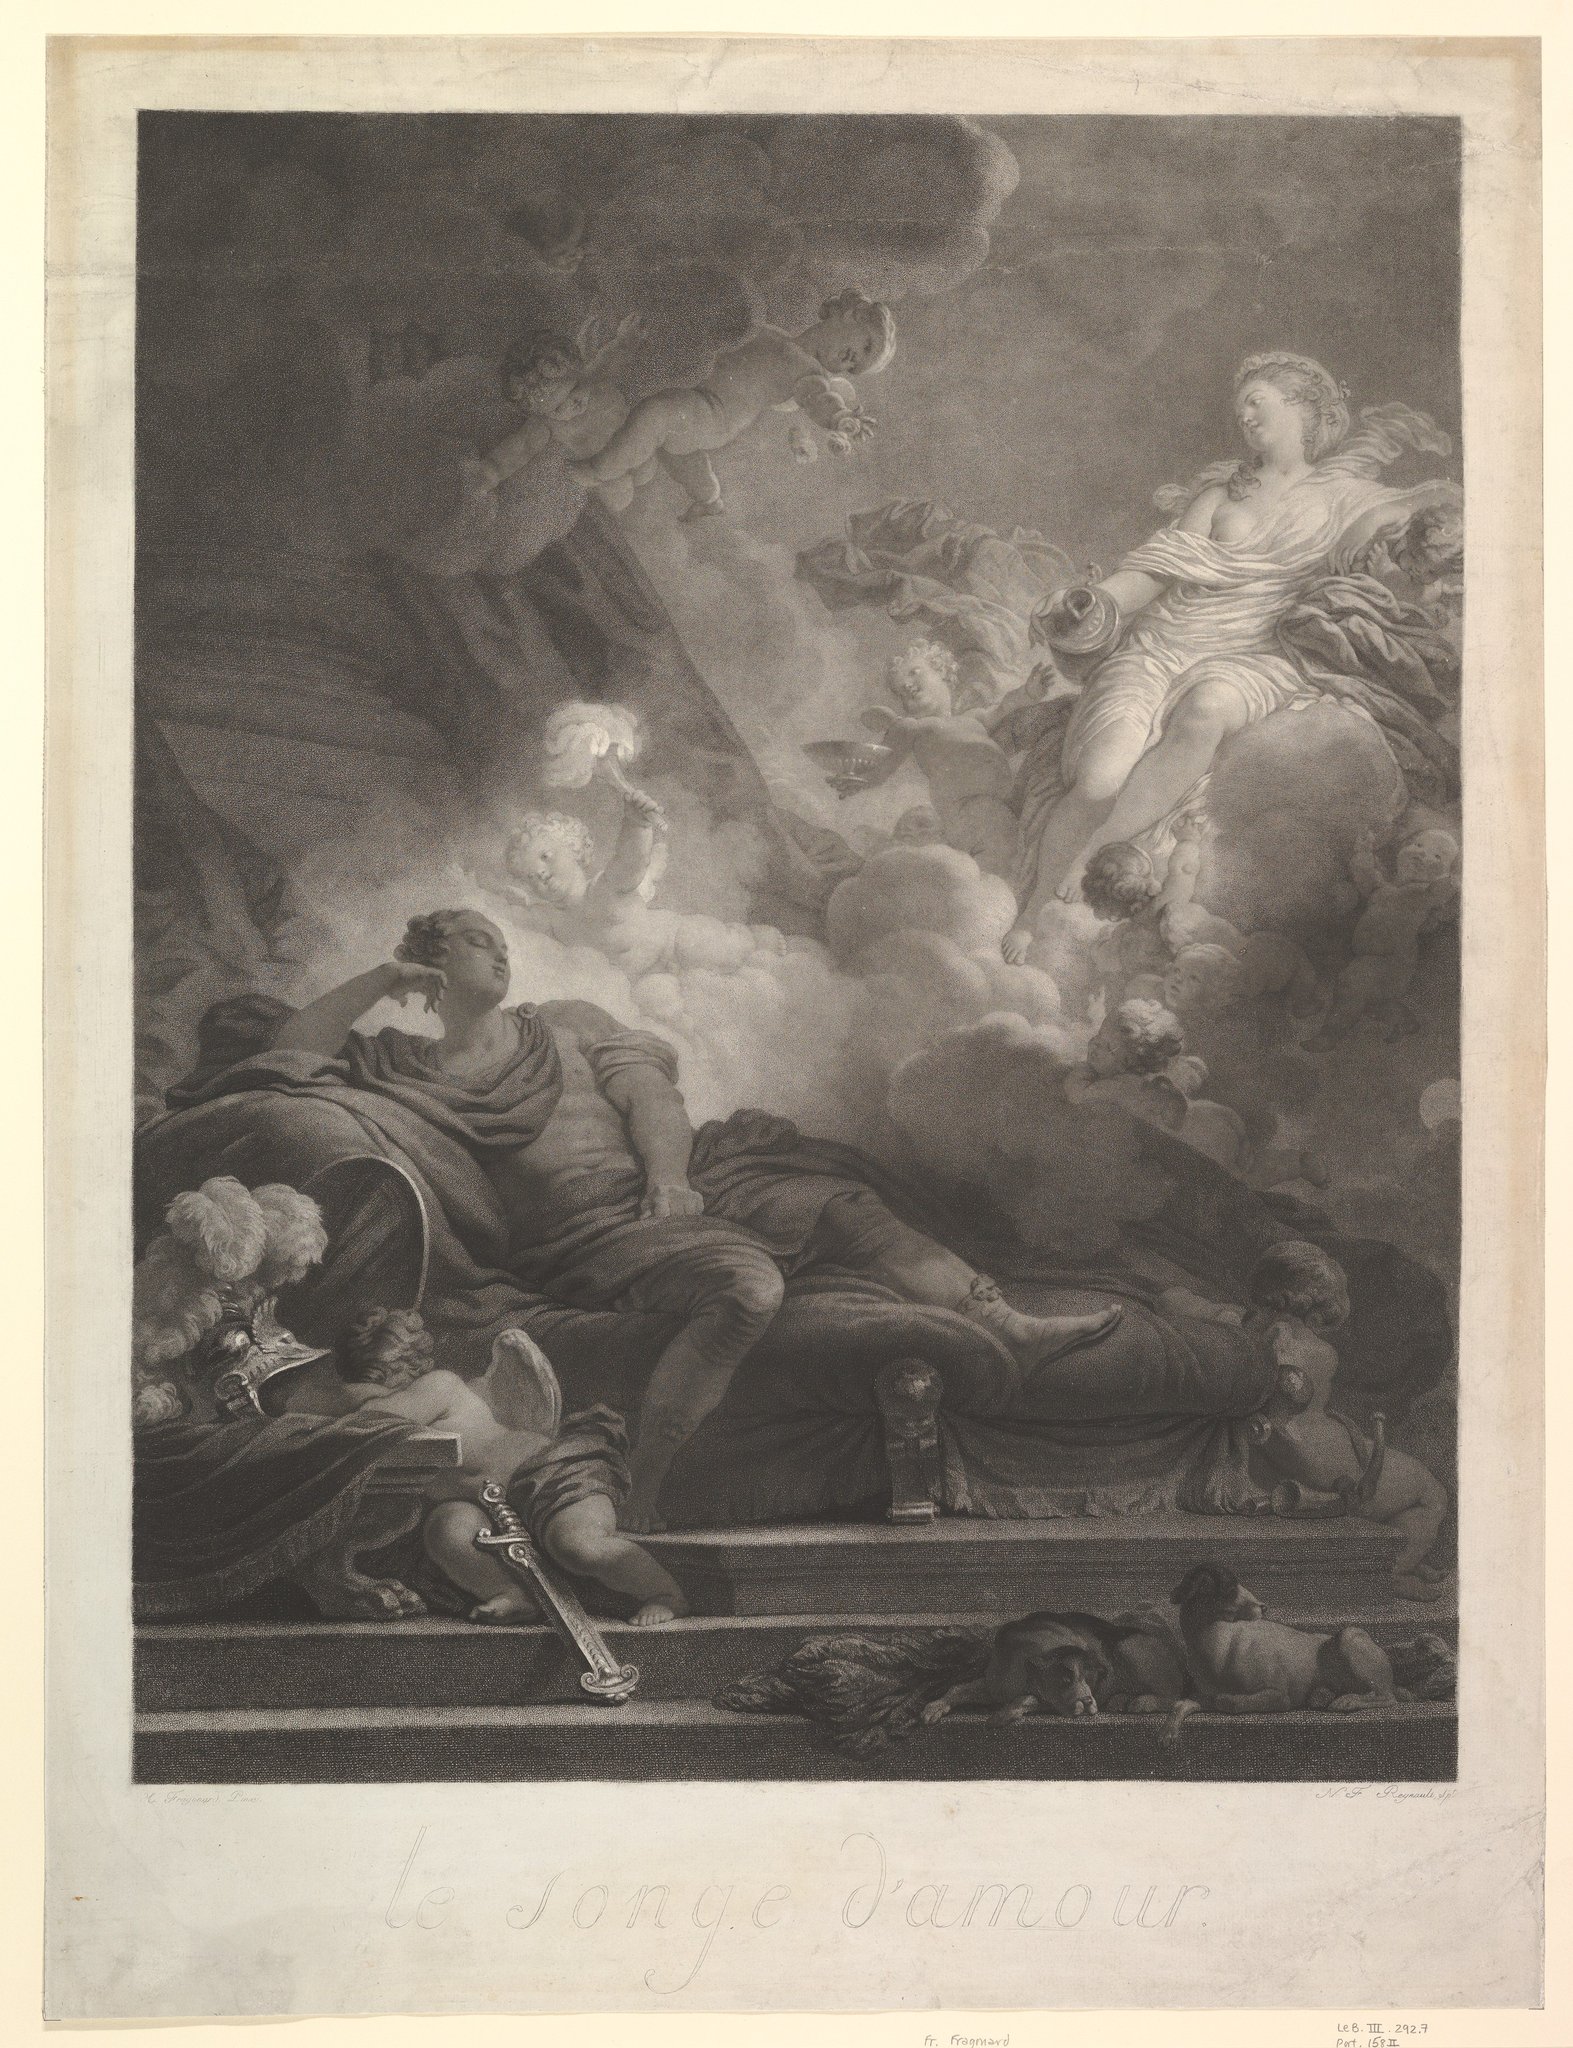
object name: print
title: Le Songe d'Amour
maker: jean honoré fragonard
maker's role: artist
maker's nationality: french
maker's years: 1732-1806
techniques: etching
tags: women